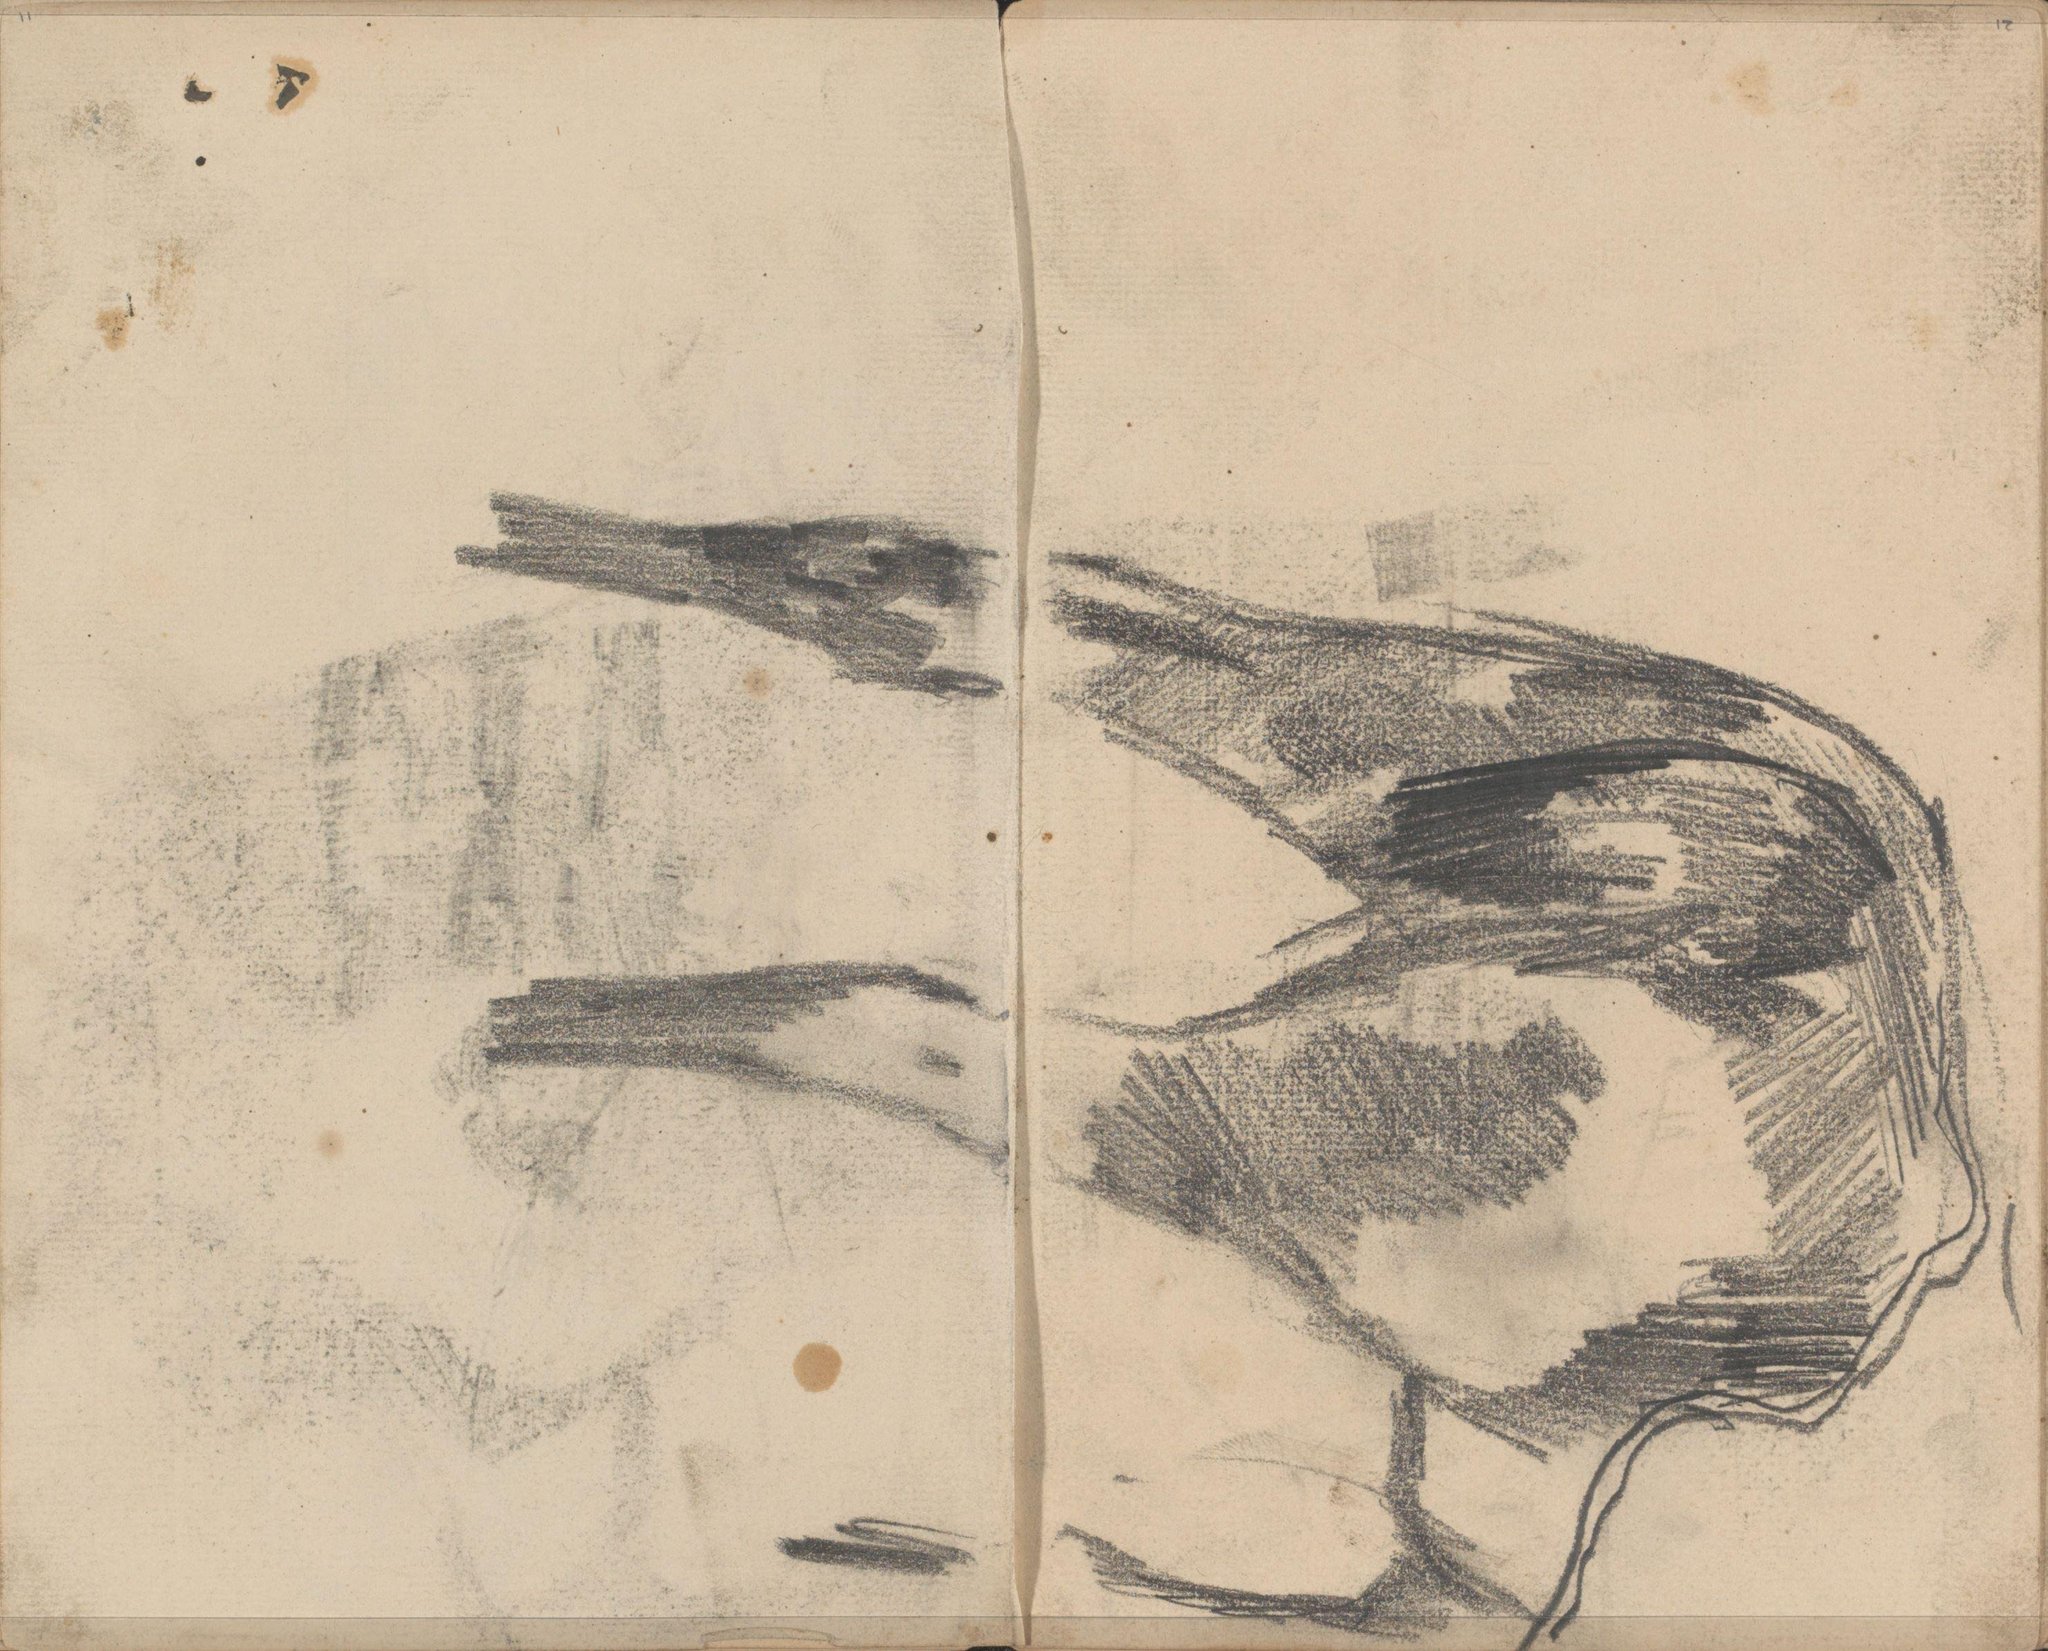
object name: sketchbook leaf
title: Achterlijf van een paard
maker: george hendrik breitner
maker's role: draughtsman, painter, print maker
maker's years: 1857-1923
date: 1887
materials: paper, pencil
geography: amsterdam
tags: horse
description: Pagina 11 en pagina 12 uit een schetsboek met 12 bladen.